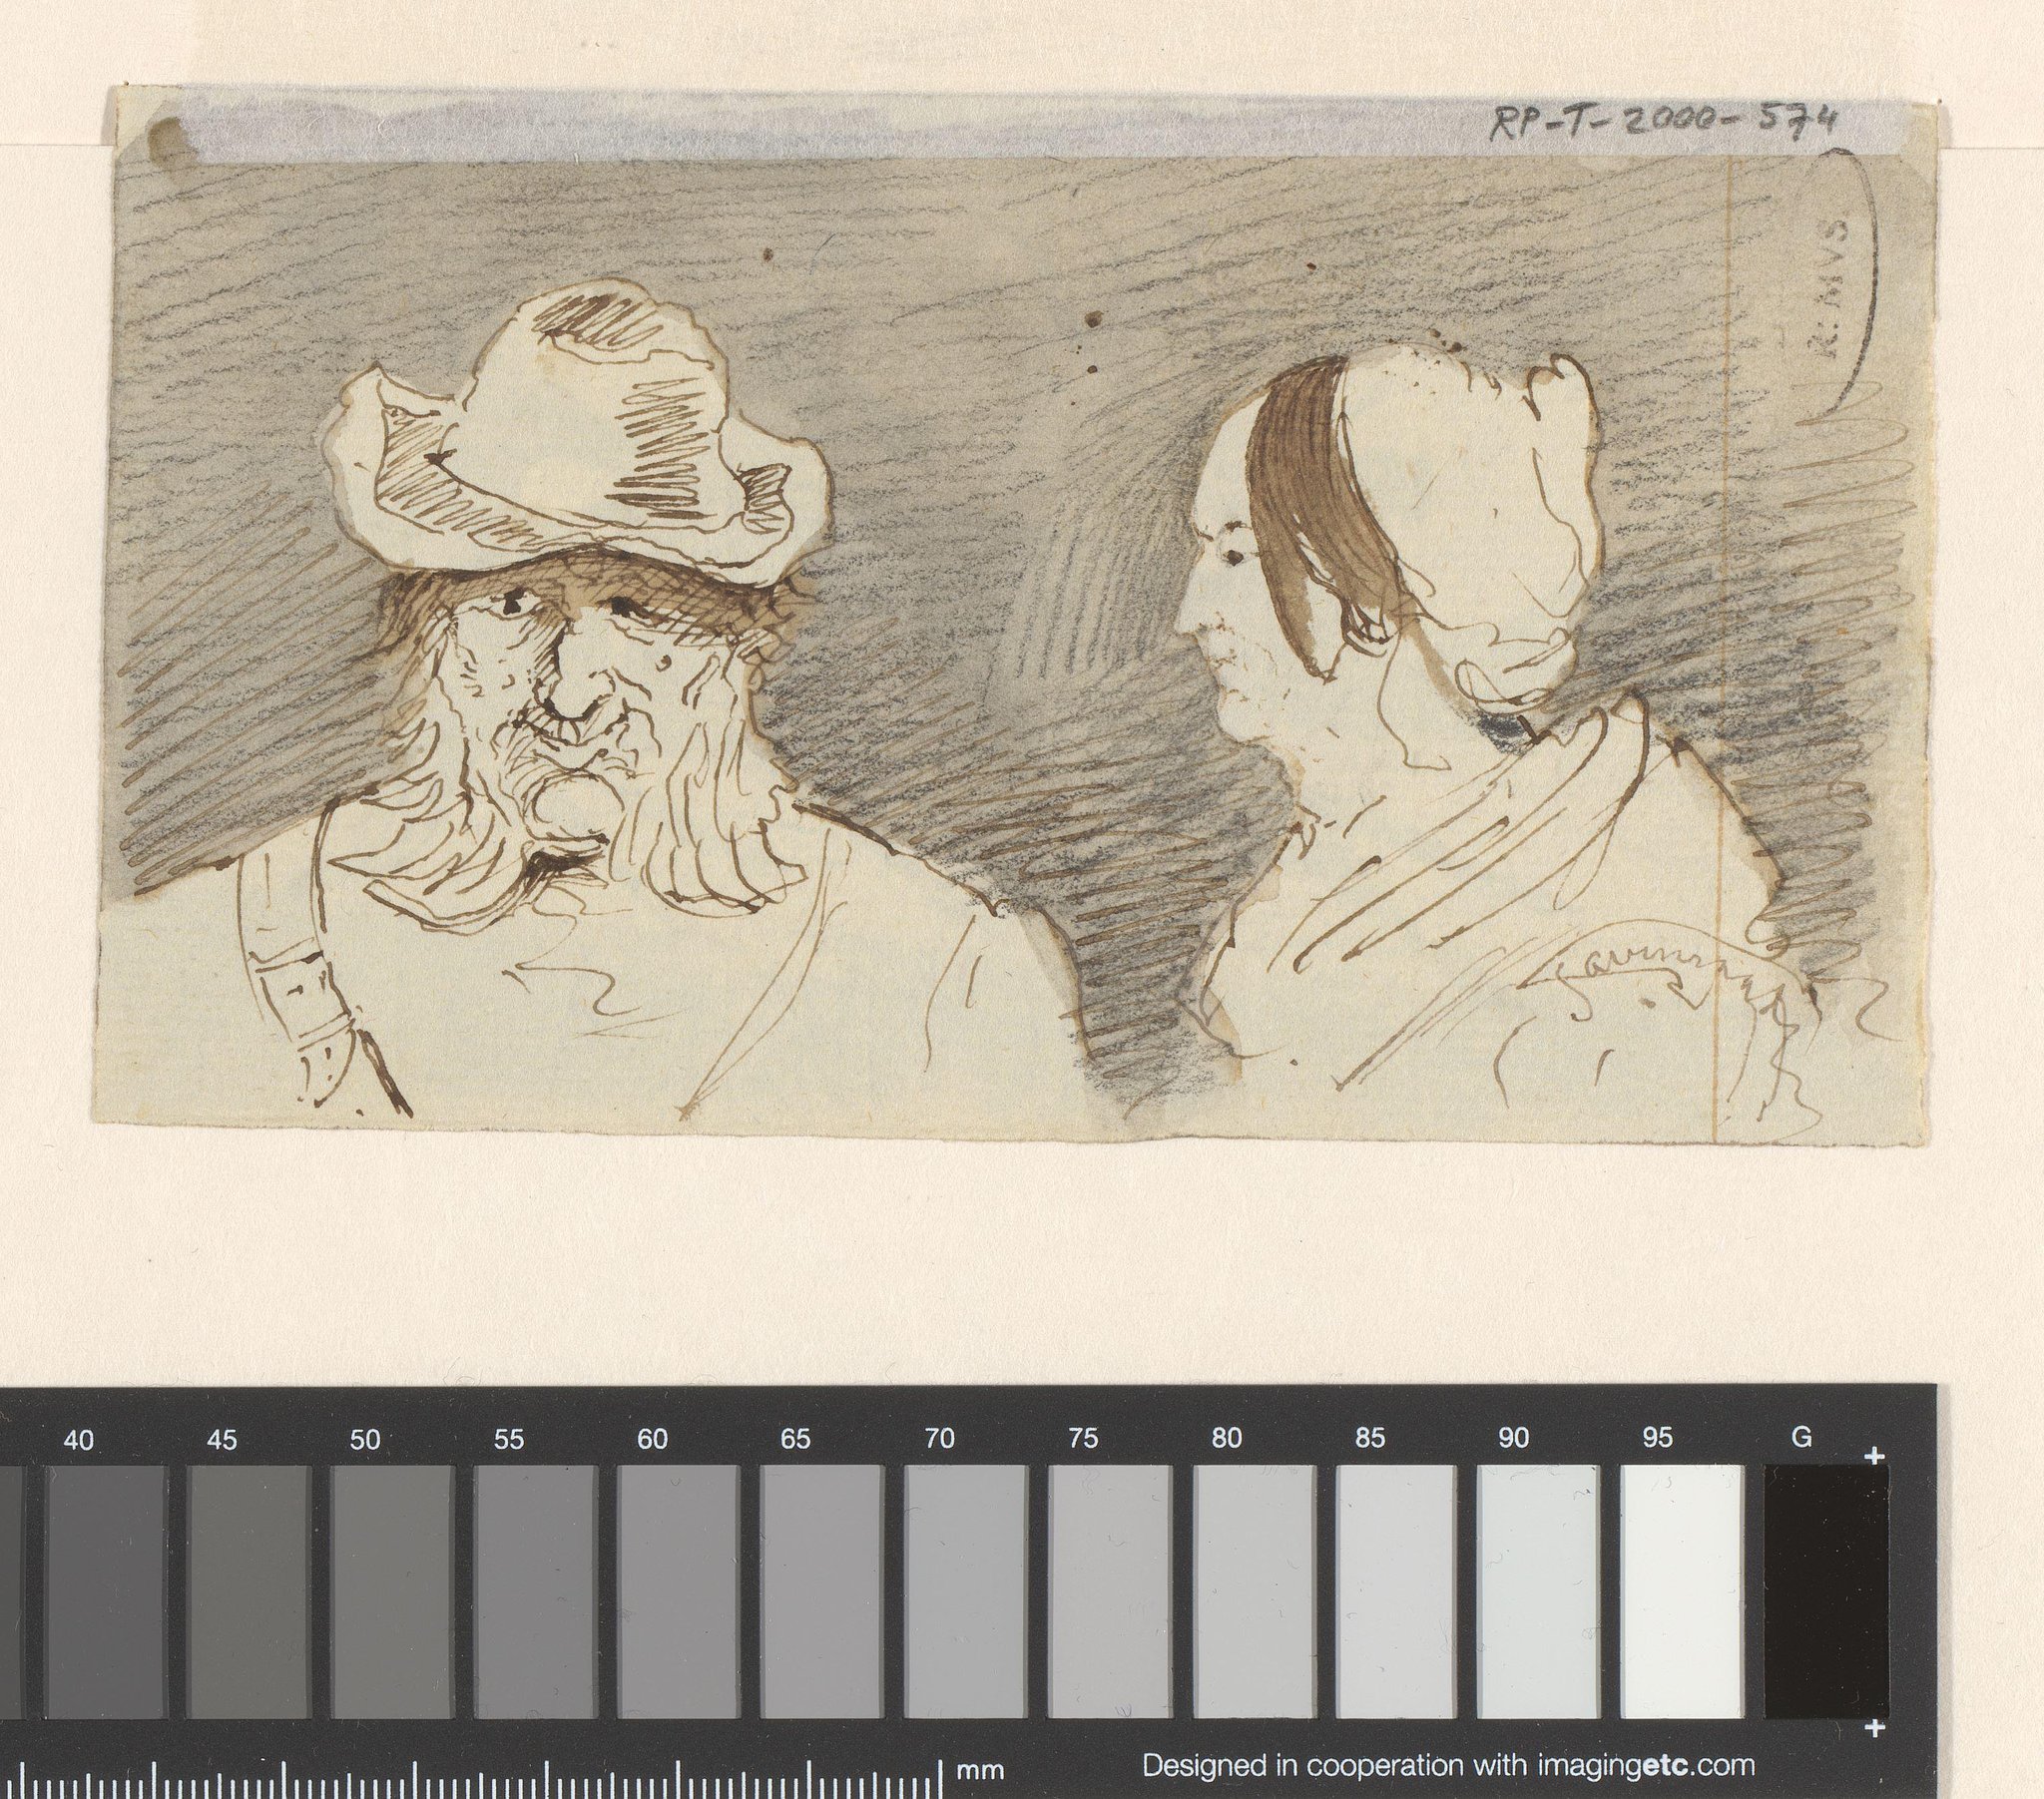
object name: drawing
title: Man en vrouw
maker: johannes tavenraat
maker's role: draughtsman, painter, print maker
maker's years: 1809-1881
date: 1840-1880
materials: ink, paper, pencil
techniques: brush, pen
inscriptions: signature: ‘Tavenraat’, collector's mark: Lugt 2228